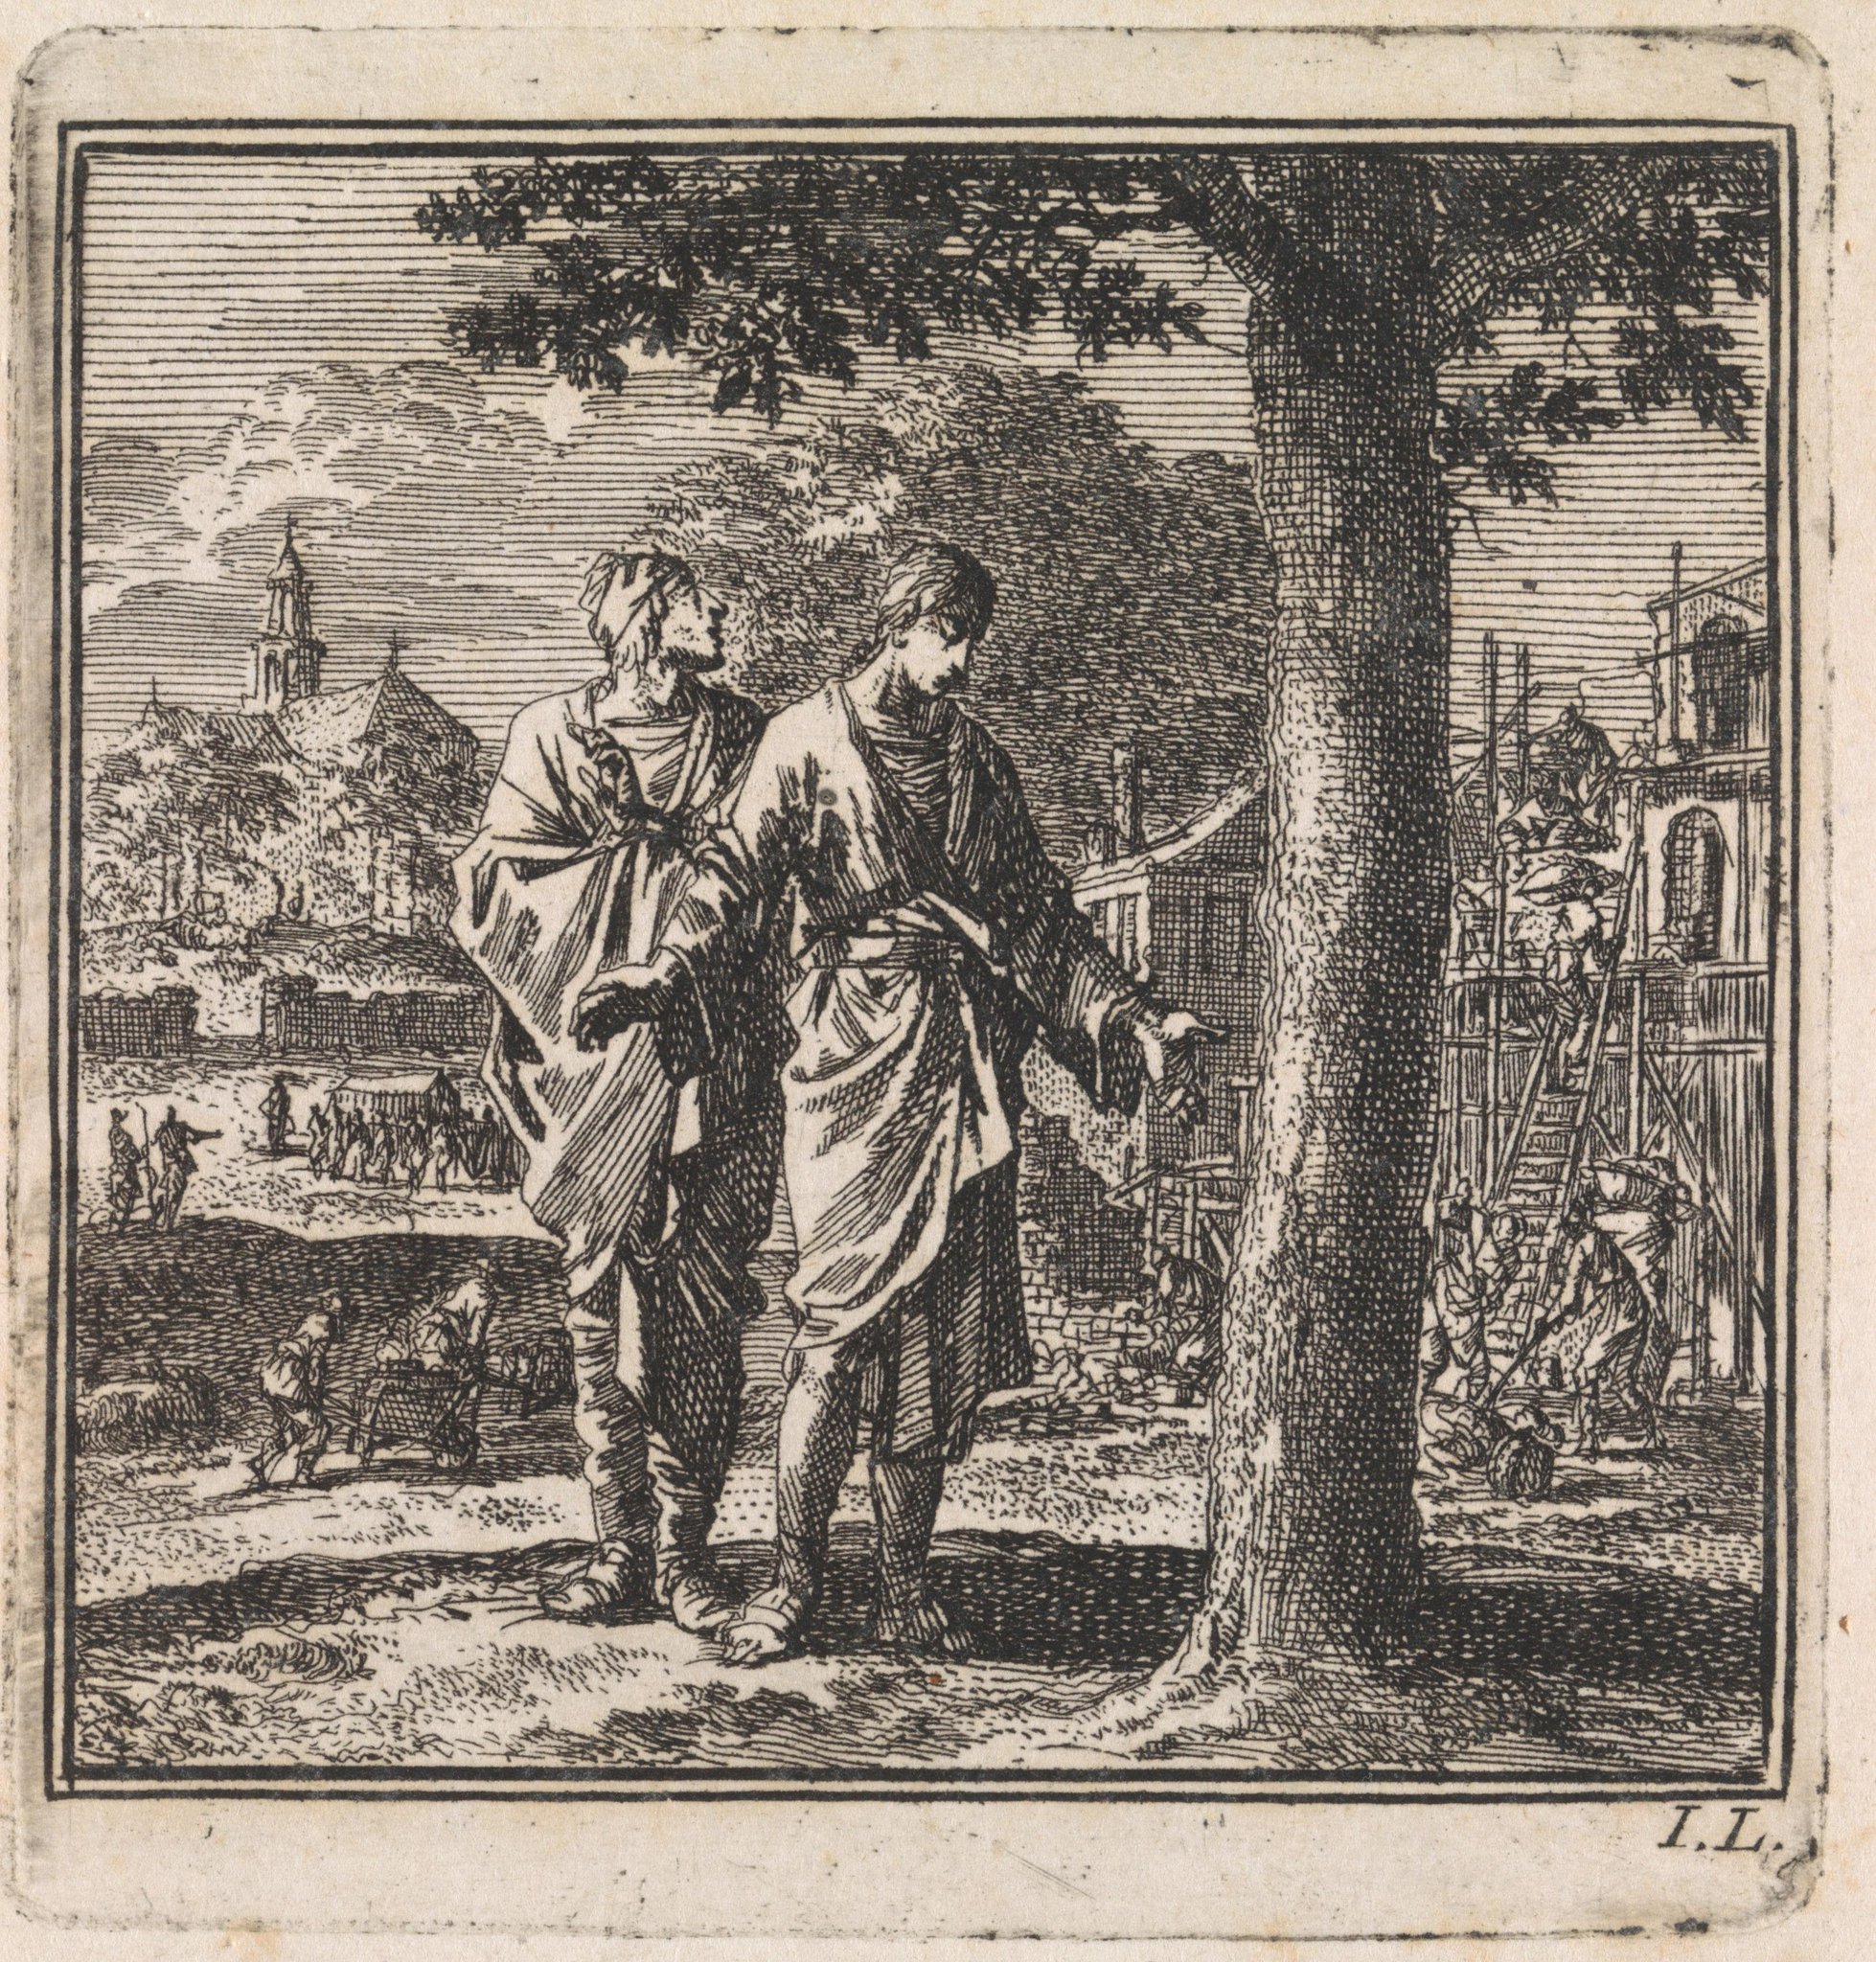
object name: print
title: Twee mannen bekijken een boom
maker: jan luyken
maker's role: draughtsman, print maker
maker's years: 1649-1712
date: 1710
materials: paper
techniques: etching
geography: amsterdam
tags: trees, cortege, funeral procession, housing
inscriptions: collector's mark: Lugt 2228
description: Illustratie uit: Luyken, Jan. De onwaardige wereld, vertoond in vyftig zinnebeelden, met godlyke spreuken en stichtelyke verzen. Amsterdam: Pieter Arentsz. II (wed.) en Cornelis van der Sys, 1710, p. 54.